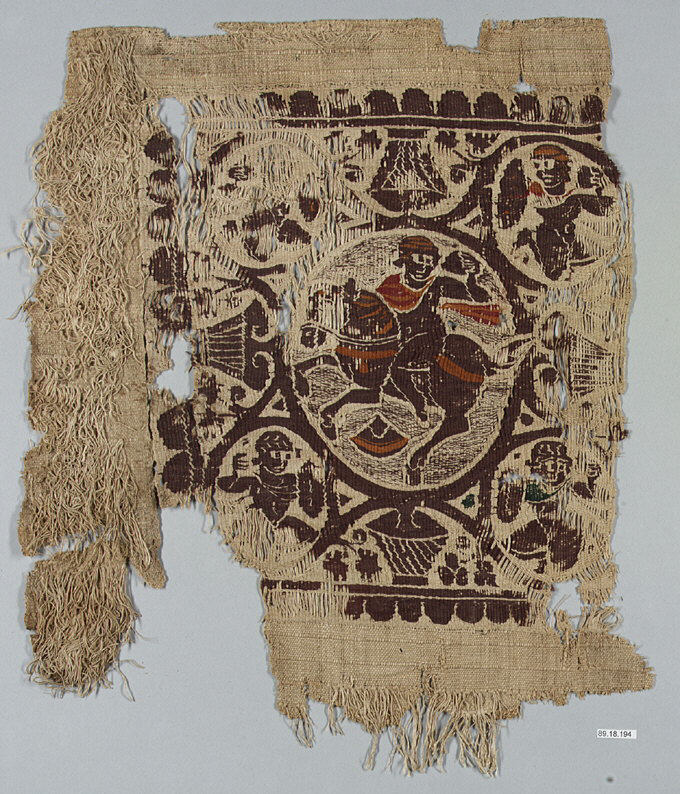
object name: textile fragment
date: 301-400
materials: linen, wool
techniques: weave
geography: egypt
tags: horses